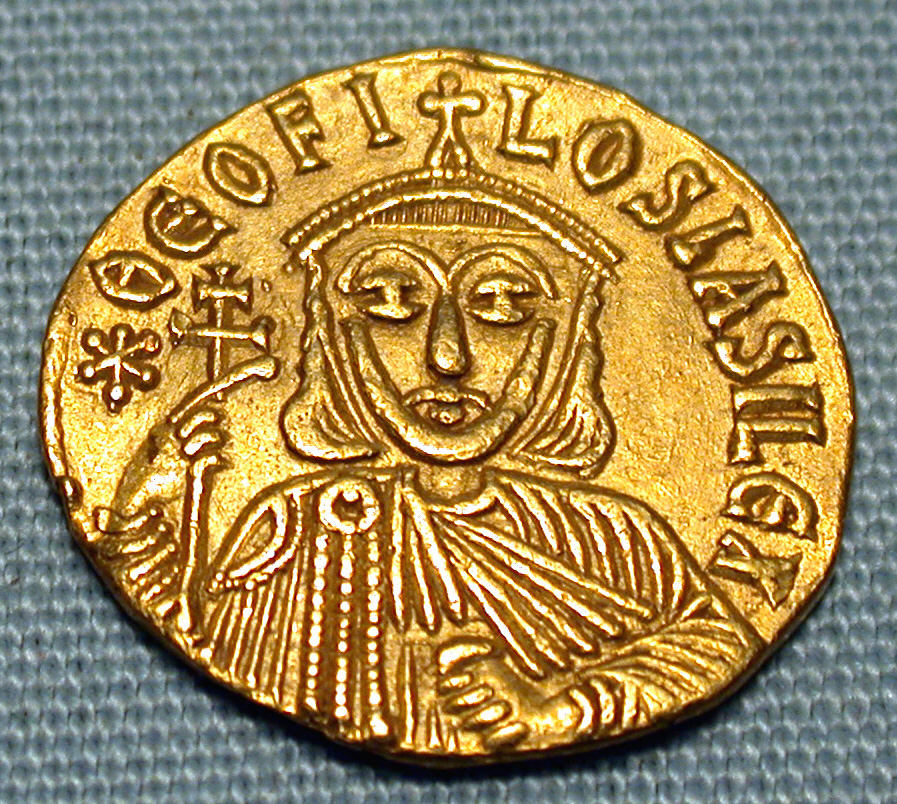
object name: coin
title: Solidus of Theophilos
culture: byzantine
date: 829-843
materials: gold